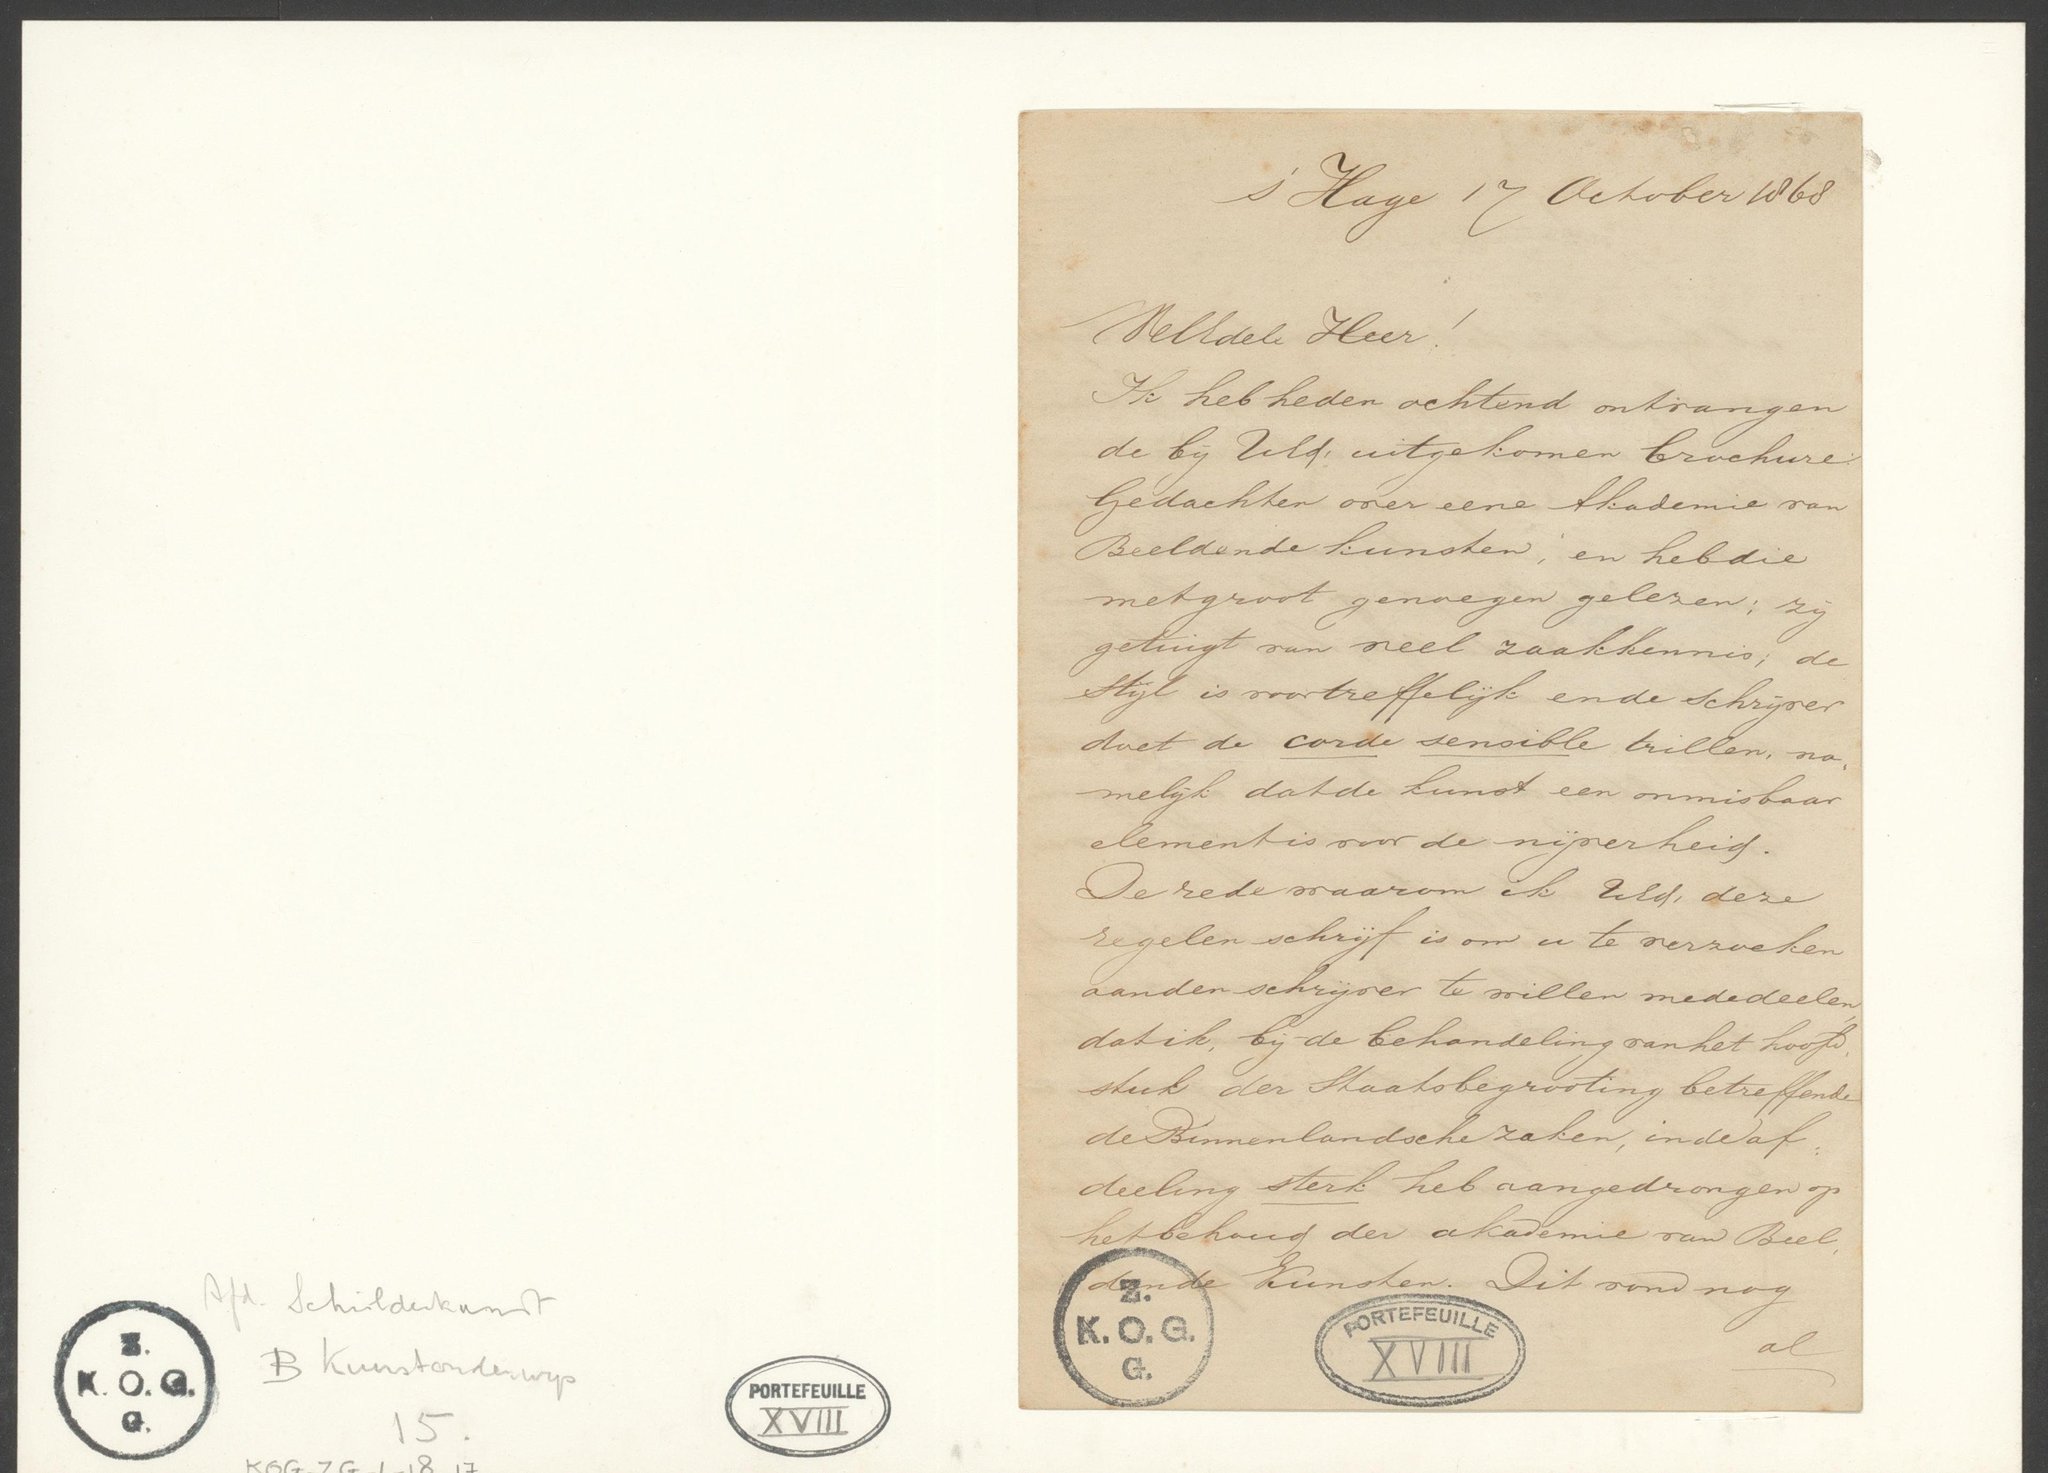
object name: letter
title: Brief van Charles Rochussen over het behoud van de Rijksakademie van Beeldende Kunsten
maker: charles rochussen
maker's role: draughtsman, painter, print maker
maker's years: 1814-1894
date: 1868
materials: ink, paper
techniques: pen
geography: the hague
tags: fruits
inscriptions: stamp, collector's mark: Lugt 1641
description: Onderwerpsrubrieken binnen de Atlas Zeden en Gewoonten: Schoone kunsten, Schilderkunst, Kunstonderwijs.